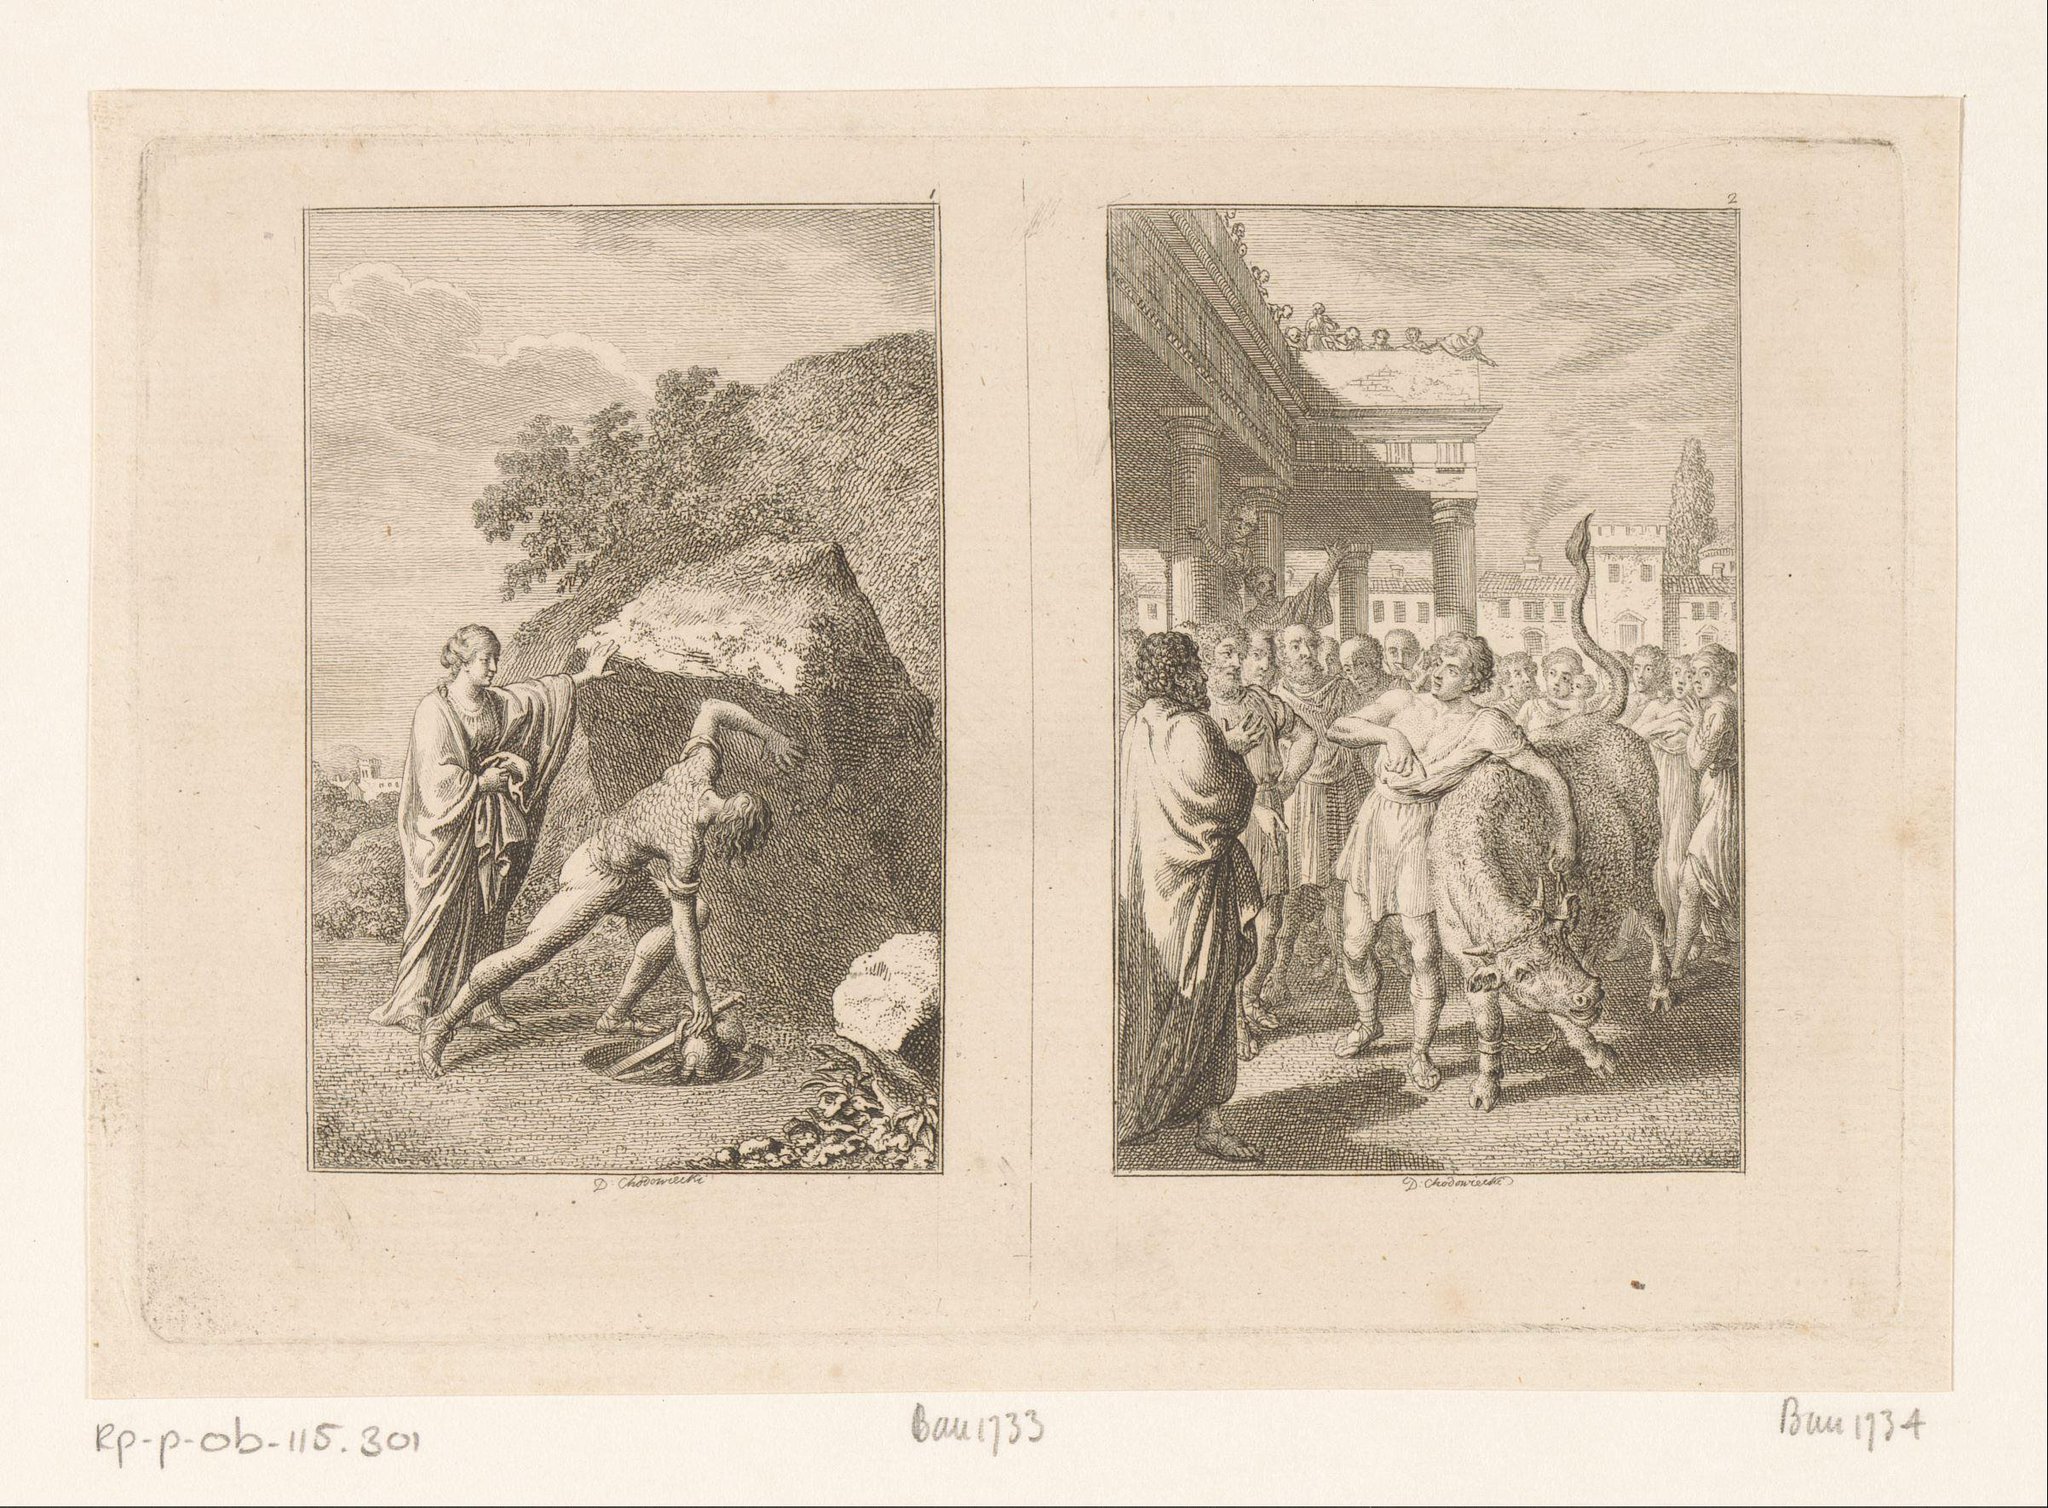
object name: print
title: Twee voorstellingen uit het leven van Theseus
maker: daniel nikolaus chodowiecki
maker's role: draughtsman, print maker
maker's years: 1726-1801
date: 1794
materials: paper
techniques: etching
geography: berlin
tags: theseus takes the sword and the sandals of his father aegeus from under the rock; usually in the presence of his mother aethra, theseus captures the bull of marathon, (story of) theseus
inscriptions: collector's mark: Lugt 2228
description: Latere staat gebruikt voor: Becker, Wilhelm Gottlieb. Taschenbuch und Almanach zum geselligen Vernügen von W. G. Becker für 1795. Leipzig: Voss und Companie, s.a.